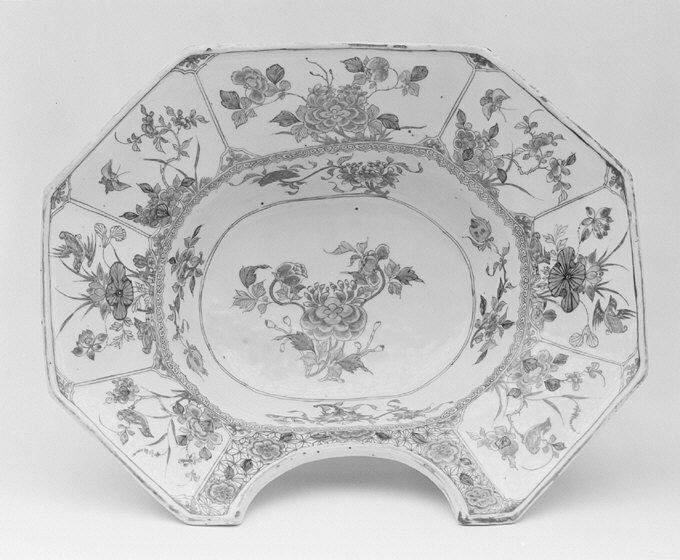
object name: shaving bowl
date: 1725-1735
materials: hard paste porcelain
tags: flowers